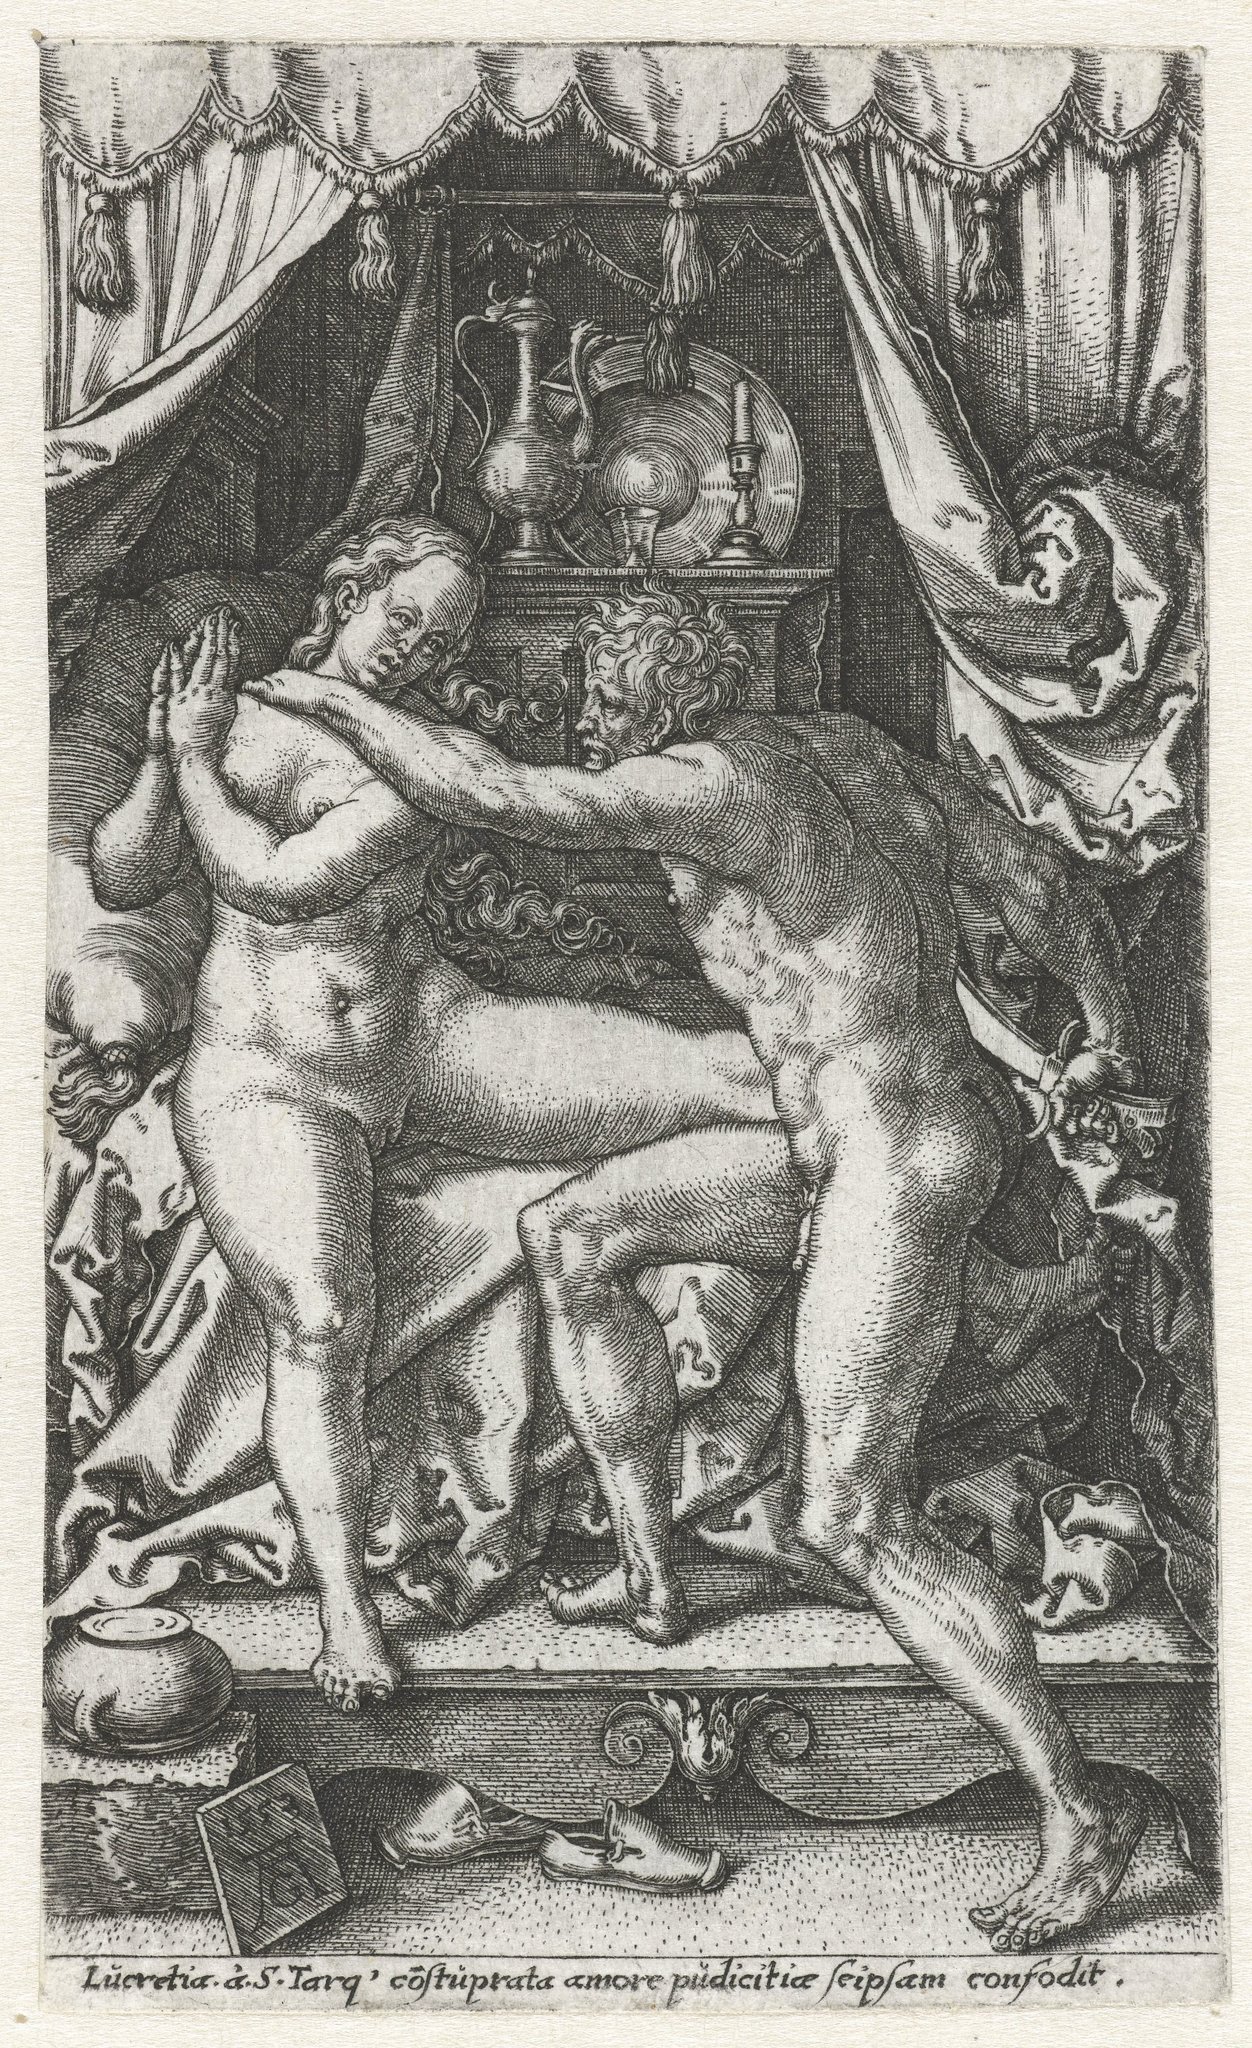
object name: print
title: Lucretia en Sextus Tarquinius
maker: heinrich aldegrever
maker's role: draughtsman, print maker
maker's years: 1502-1561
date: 1553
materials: paper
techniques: engraving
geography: germany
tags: the rape of lucretia: sextus tarquin threatens her with a dagger or a sword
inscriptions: date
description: Lucretia naakt zittend op haar bed, wordt bij de keel gegrepen door de eveneens naakte Sextus Tarquinius, die een zwaard in zijn rechterhand heeft. Hij dreigt haar te doden als zij zich niet aan hem geeft. Onder de voorstelling een regel tekst in het Latijn.